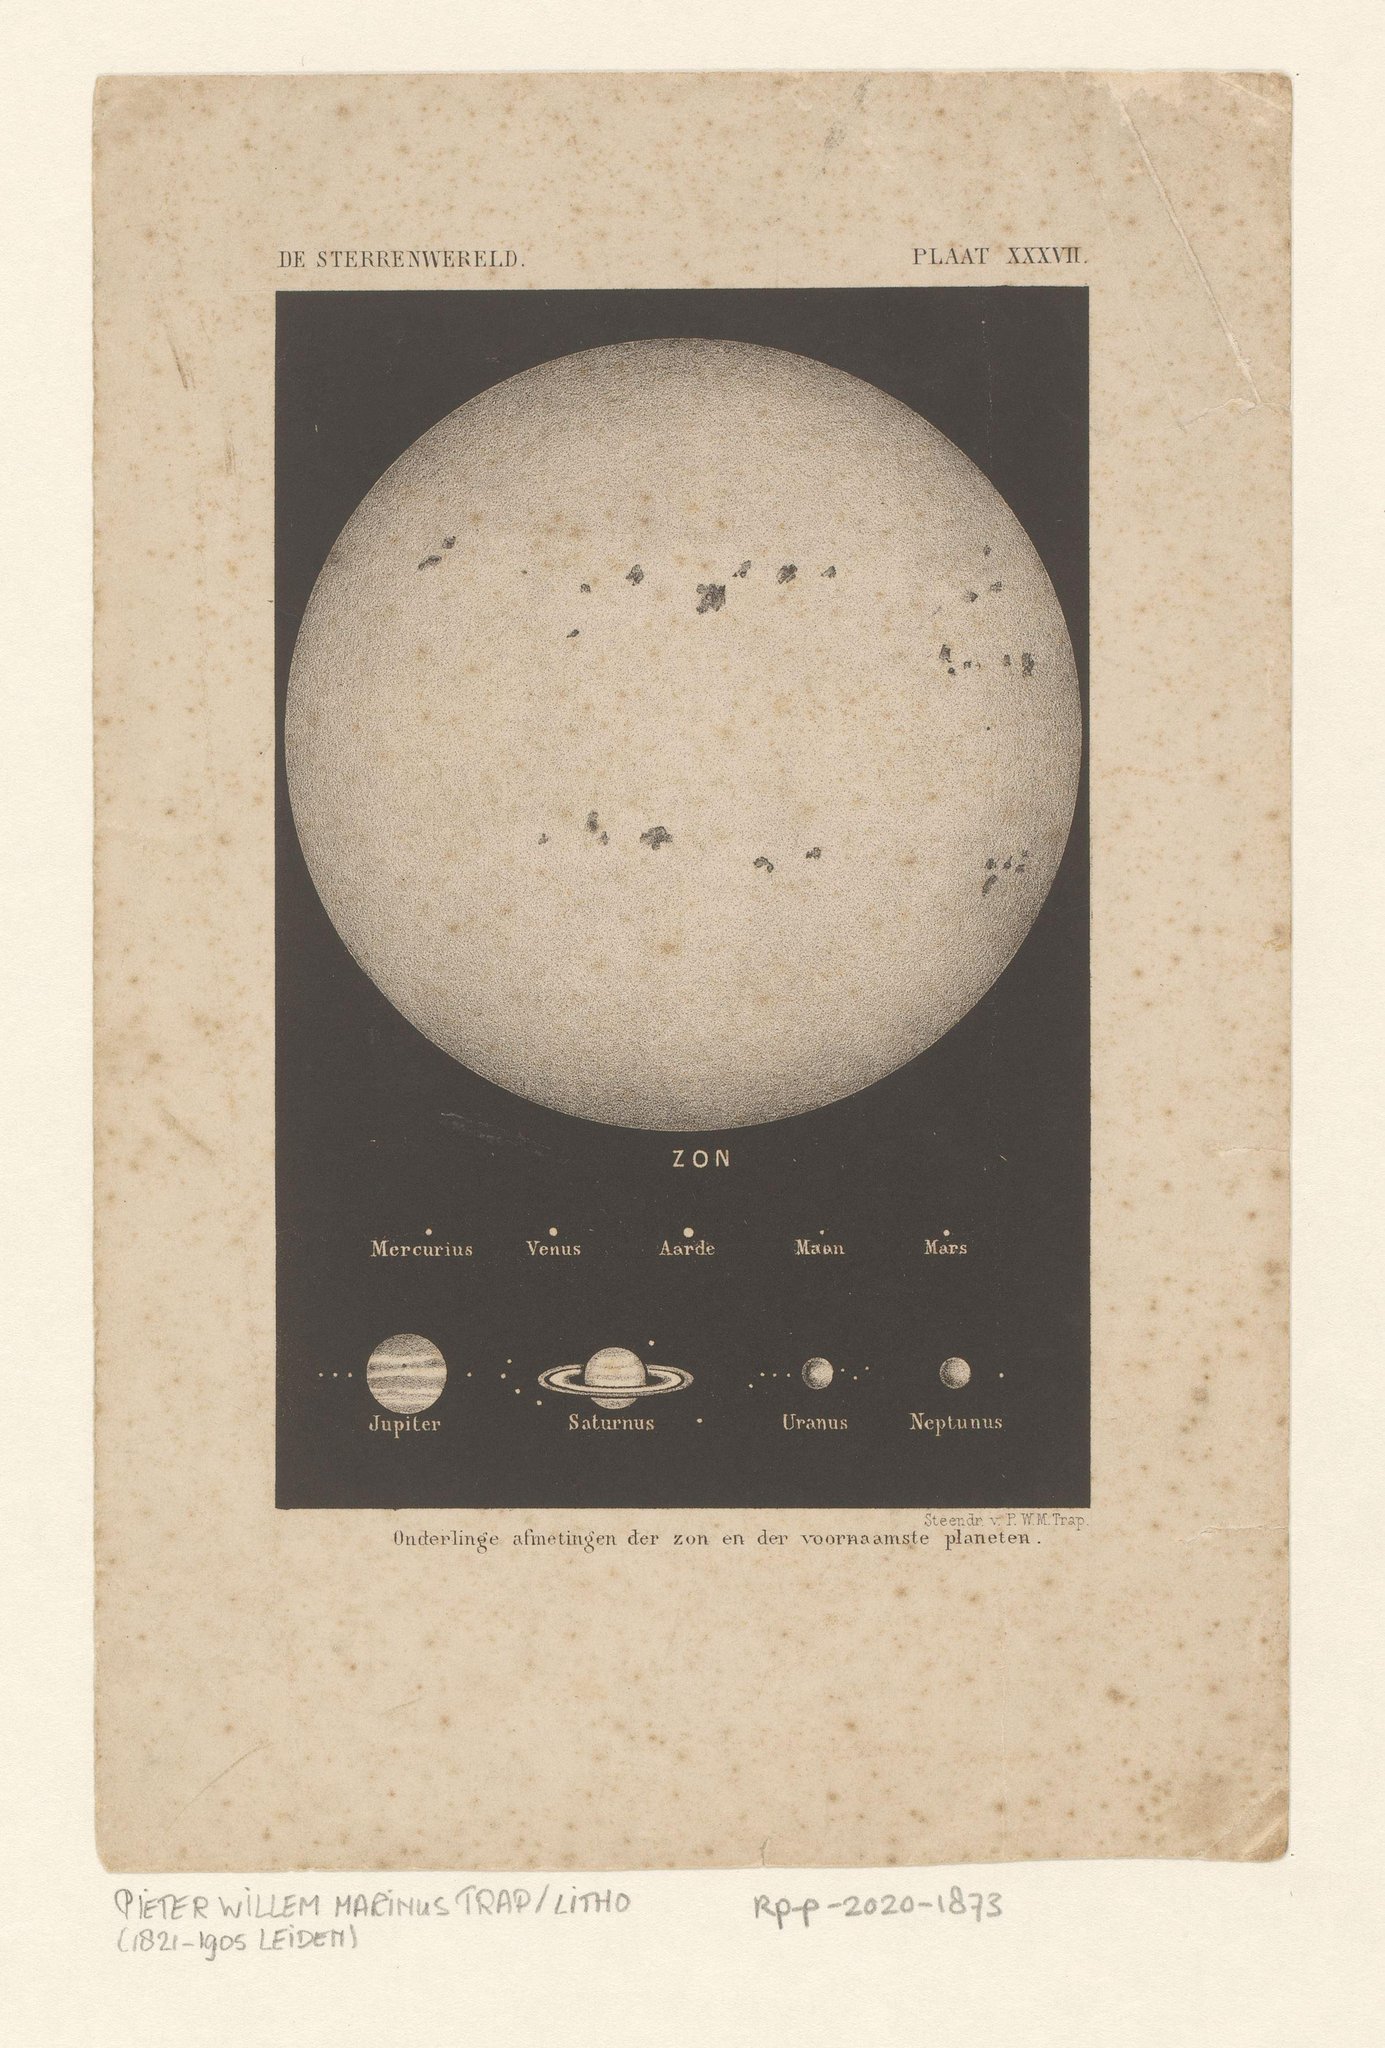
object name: book illustration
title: Afmeting van de zon in vergelijking tot negen planeten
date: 1873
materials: paper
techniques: lithograph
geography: leiden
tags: earth, world as celestial body, sun as celestial body, planets (except the earth)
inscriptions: collector's mark: Lugt 2228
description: Prent uit: Brinkman, Bernardus. De Sterrenwereld, Guillemin gevolgd. Leiden: J.W. van Leeuwen, 1873.